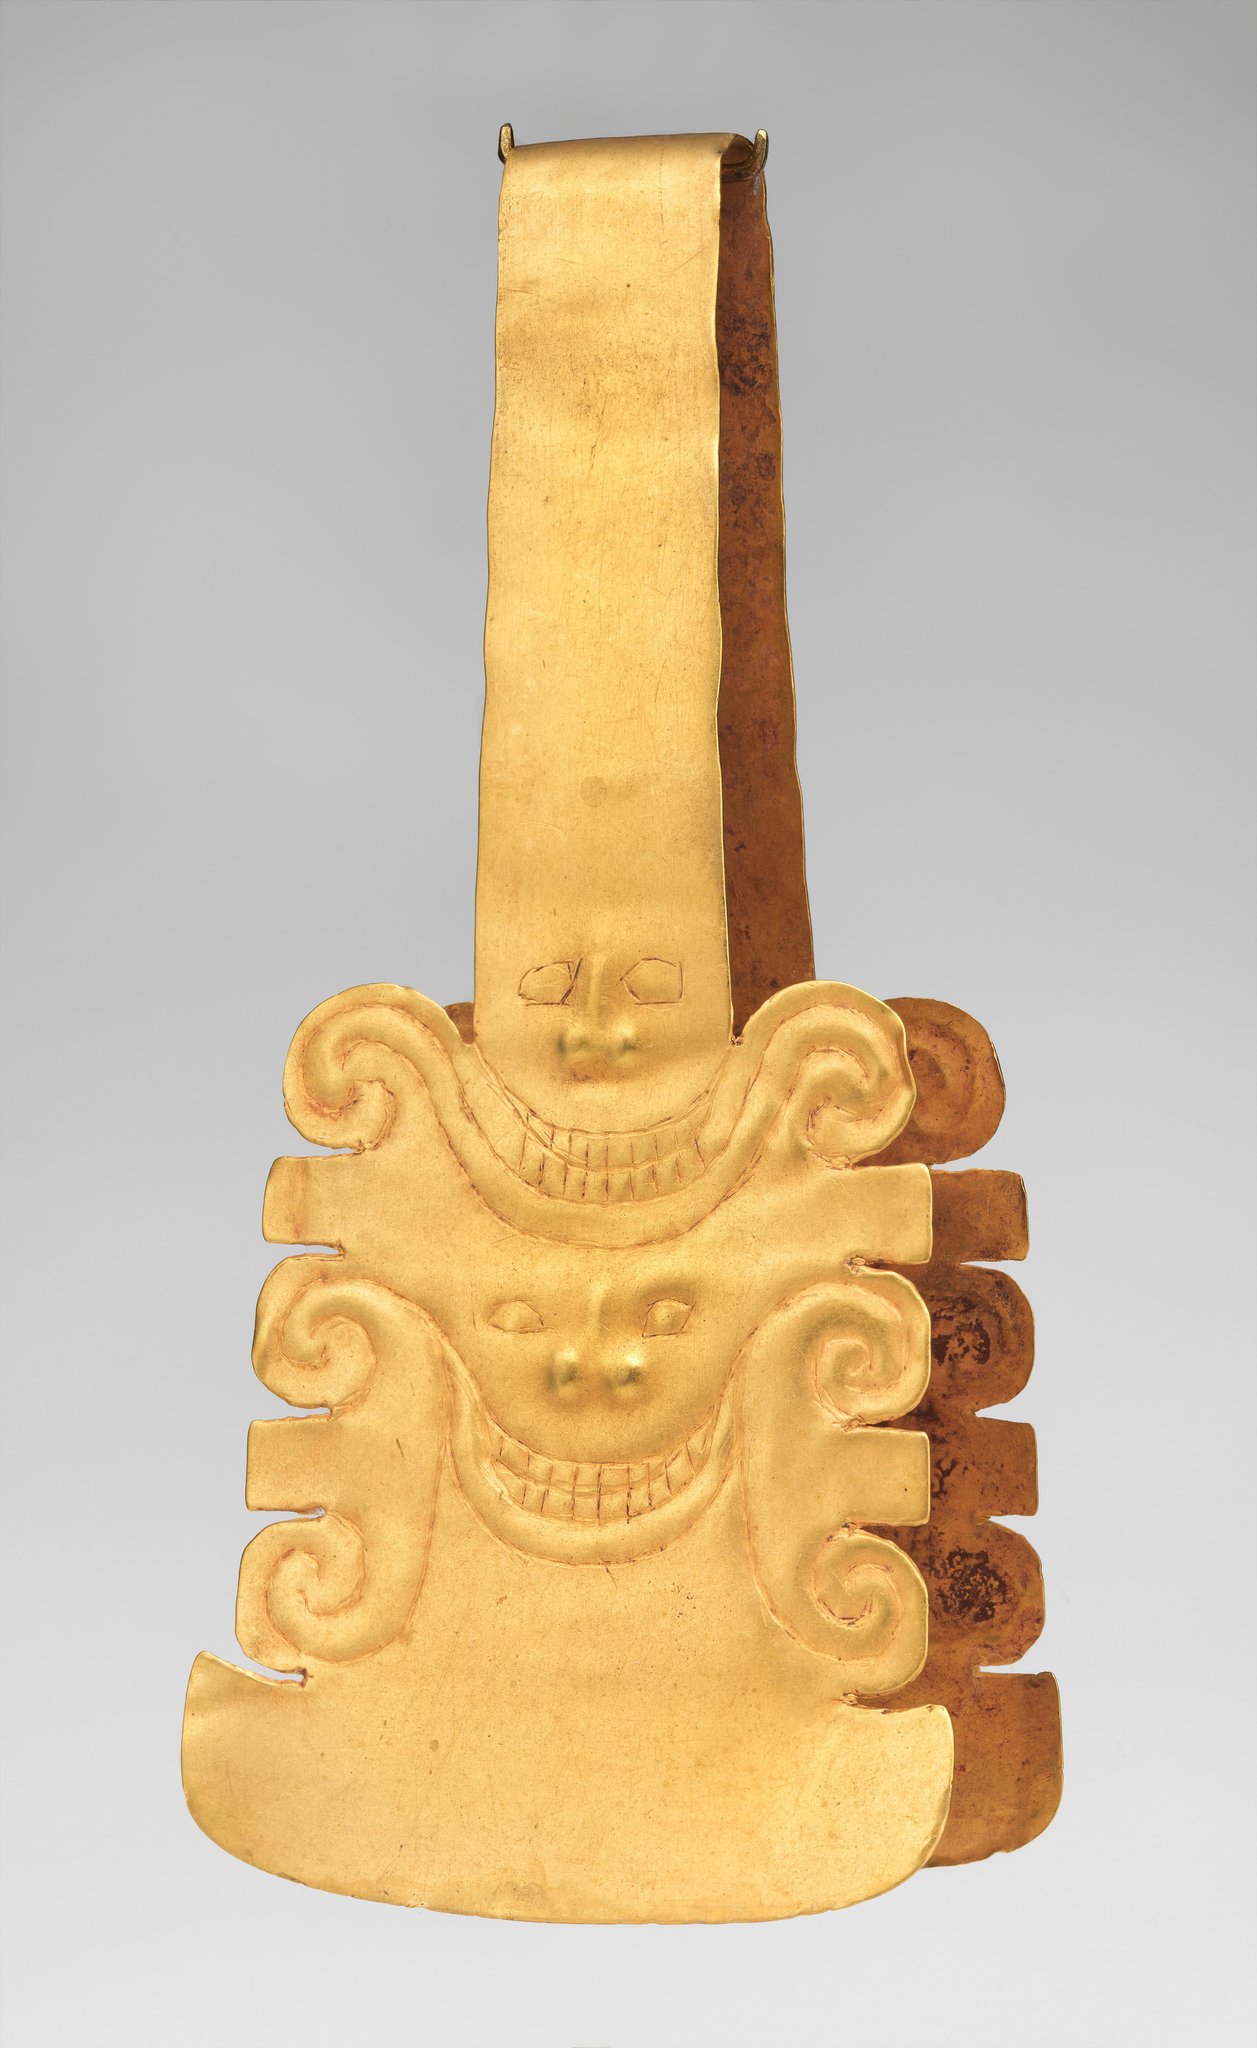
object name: tweezer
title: Ornamented Tweezer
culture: calima-yotoco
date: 100 BCE-400 CE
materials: gold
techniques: hammering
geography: colombia